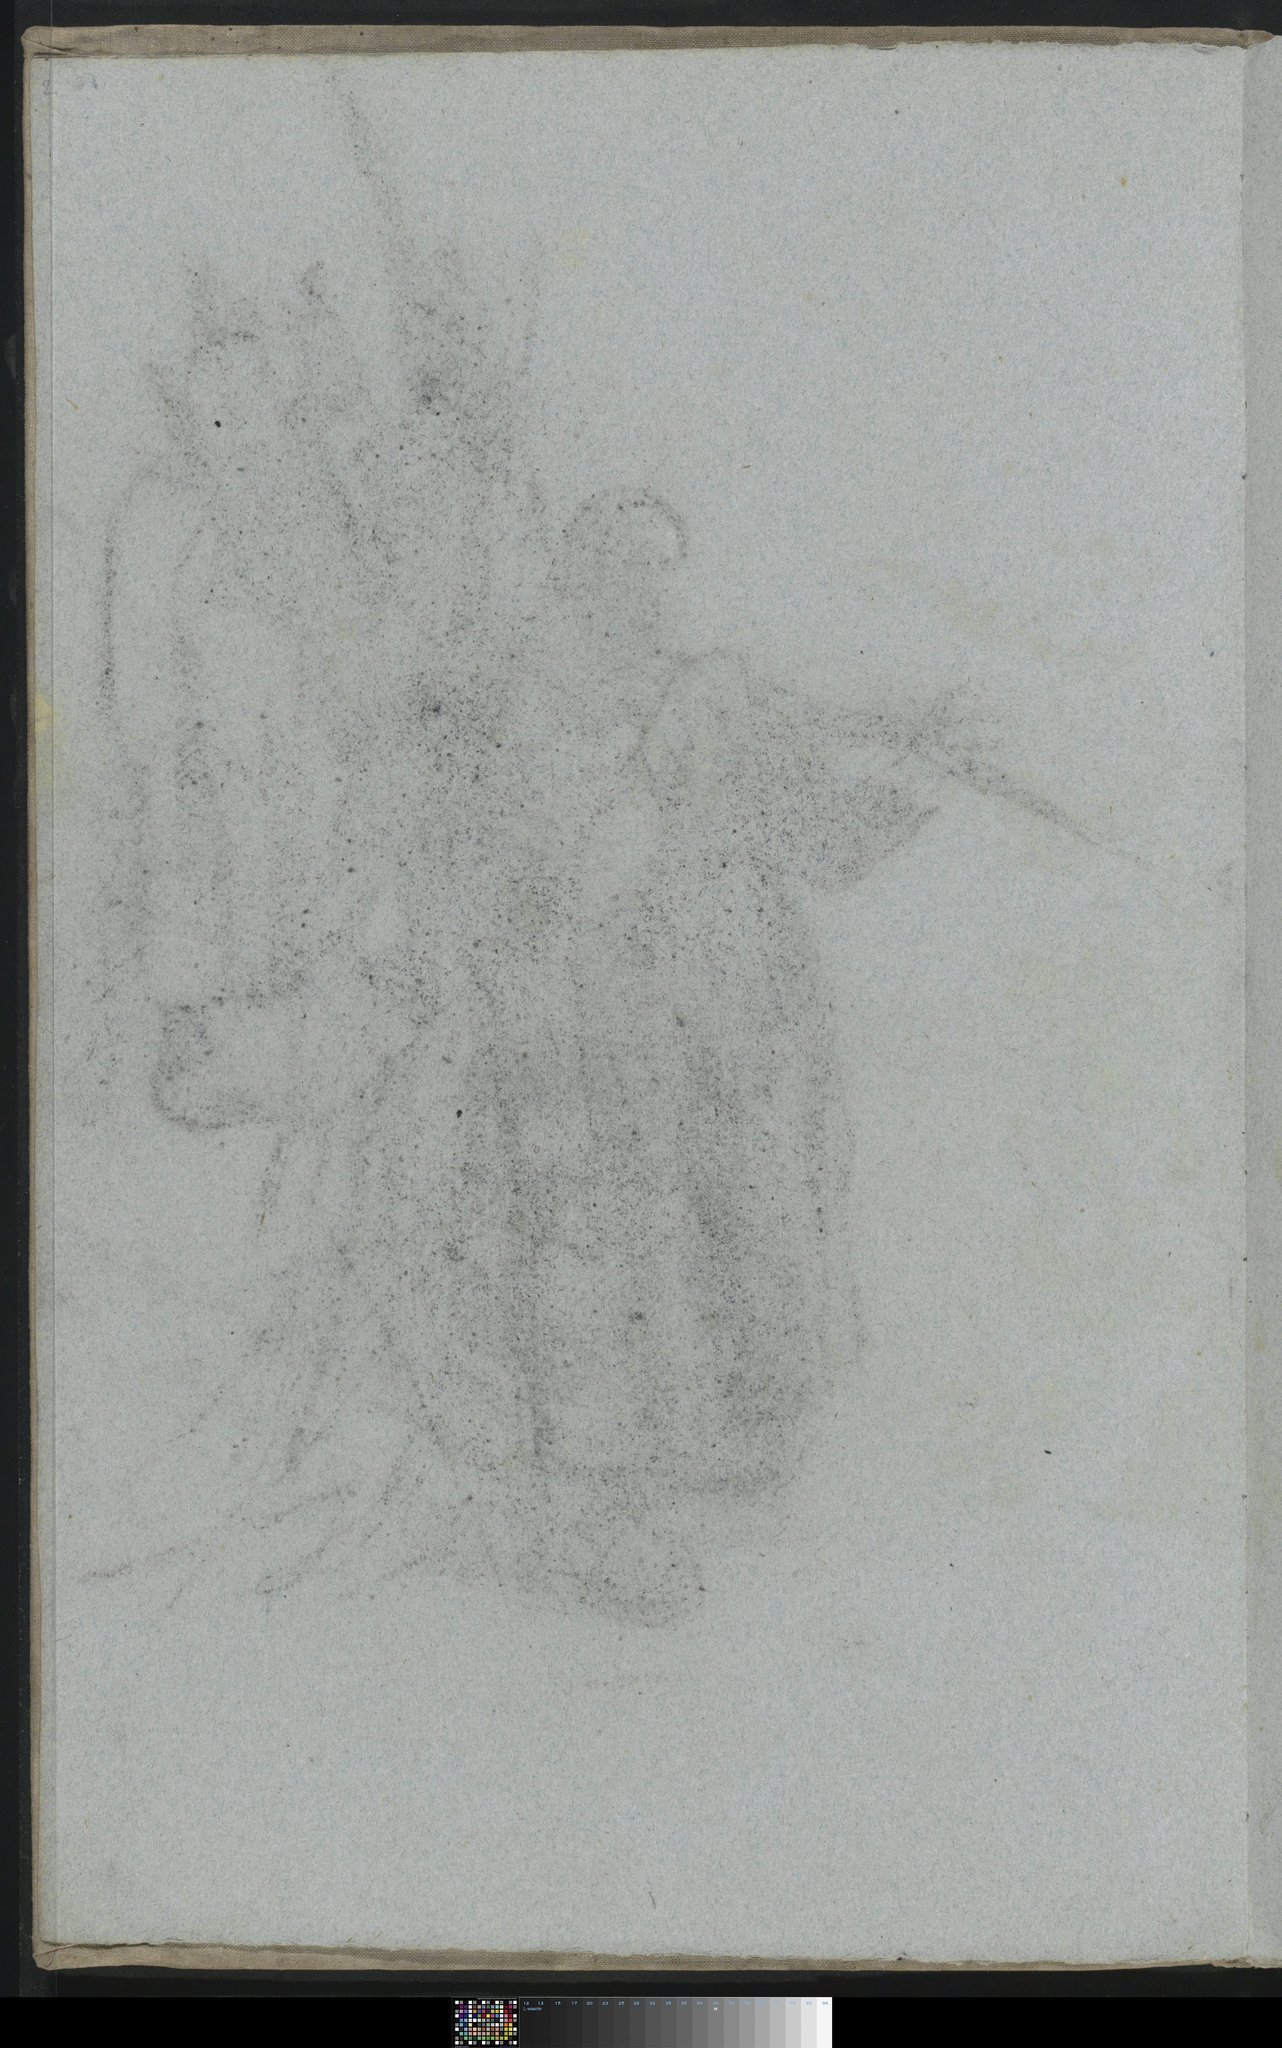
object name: sketchbook leaf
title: Abklatsch van de krijttekening op pagina 3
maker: willem witsen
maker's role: draughtsman, painter, print maker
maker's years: 1860-1923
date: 1884-1887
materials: paper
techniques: printmaking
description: Pagina 2 uit een schetsboek met 42 bladen vervaardigd rond de Ewijkshoeve.